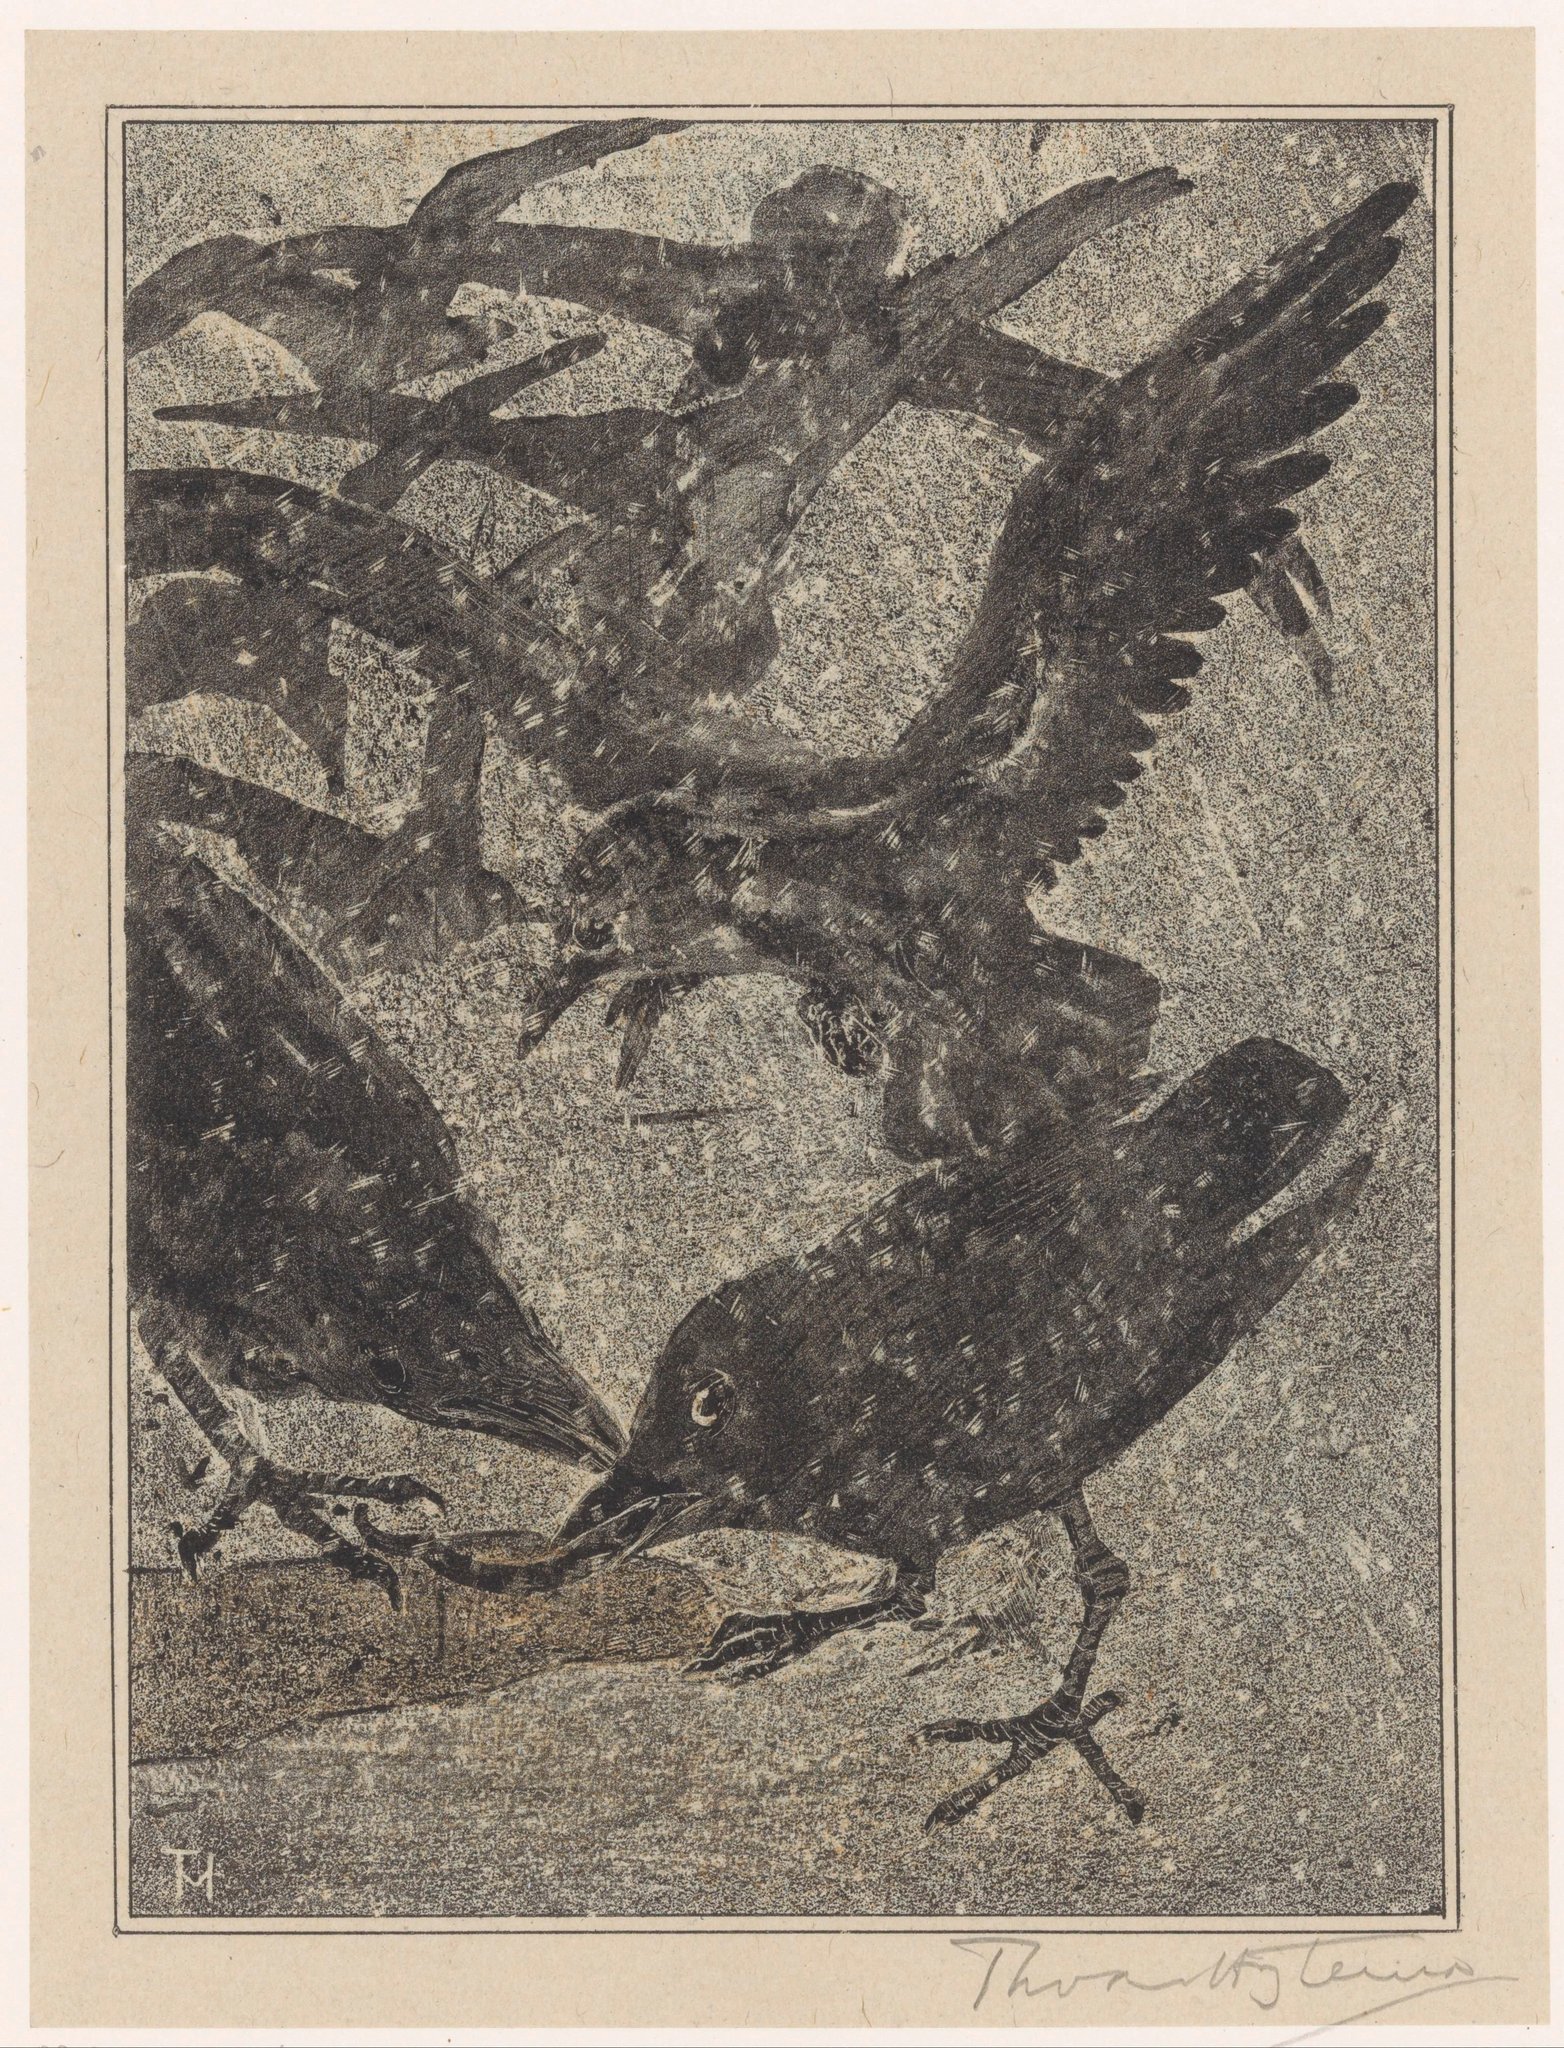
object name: print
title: Kraaien in de sneeuw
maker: theo van hoytema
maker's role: draughtsman, painter, print maker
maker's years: 1863-1917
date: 1878-1906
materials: paper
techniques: lithograph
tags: song-birds: crow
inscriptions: collector's mark: Lugt 2233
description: Prent is een proefdruk voor kalenderblad februari 1906.